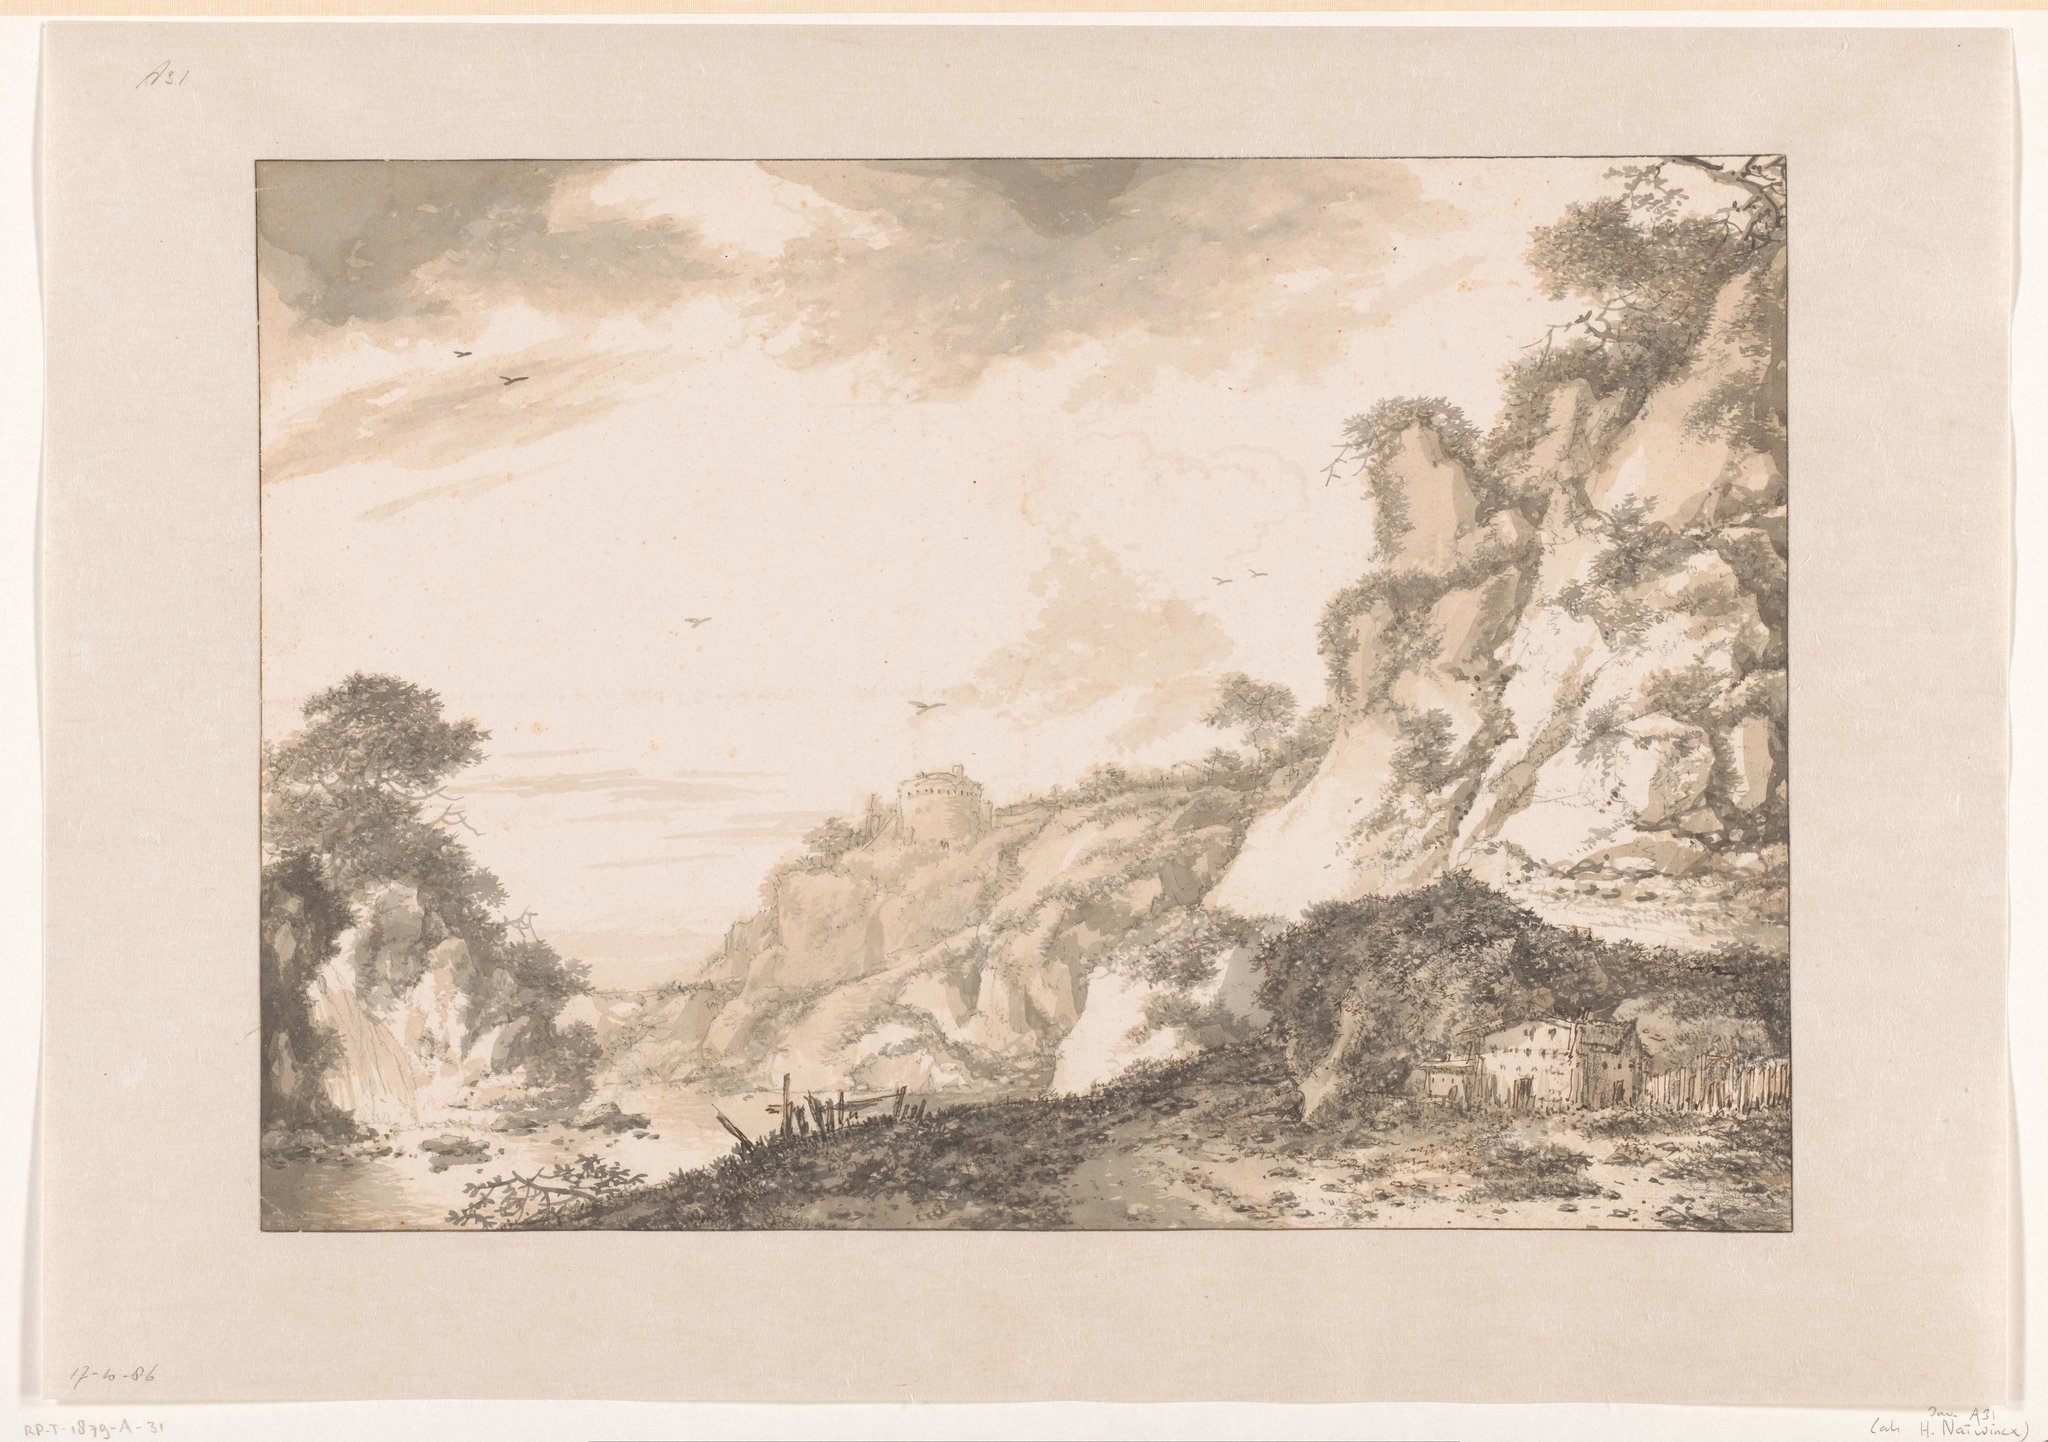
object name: drawing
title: Bergachtig landschap met rechts een boerderij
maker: herman naiwincx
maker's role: draughtsman, print maker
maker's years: 1623-1670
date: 1634-1654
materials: chalk, ink, paper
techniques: brush, pen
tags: low hill country, farm (building)